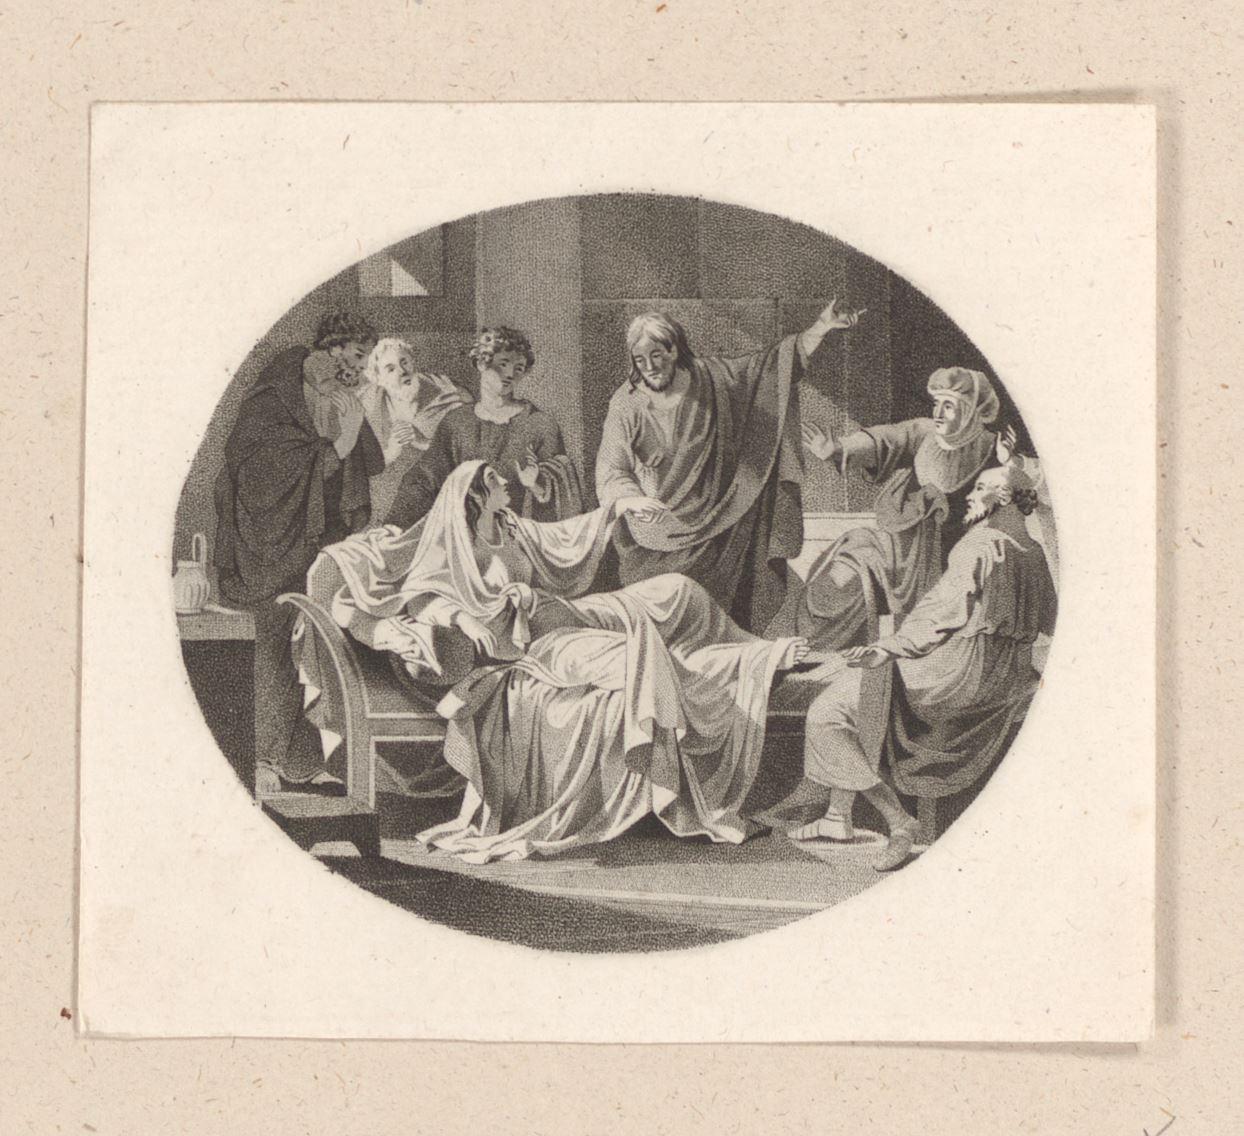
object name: album leaf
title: Opstanding van Cidli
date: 1804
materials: paper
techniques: engraving, etching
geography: haarlem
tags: raising from the dead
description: Gebruikt als boekillustratie in: Adriaan Pietersz. Loosjes. Semida en Cidli of de Hope der opstanding. Haarlem: A. Loosjes, 1804. Heruitgegeven in 1816.